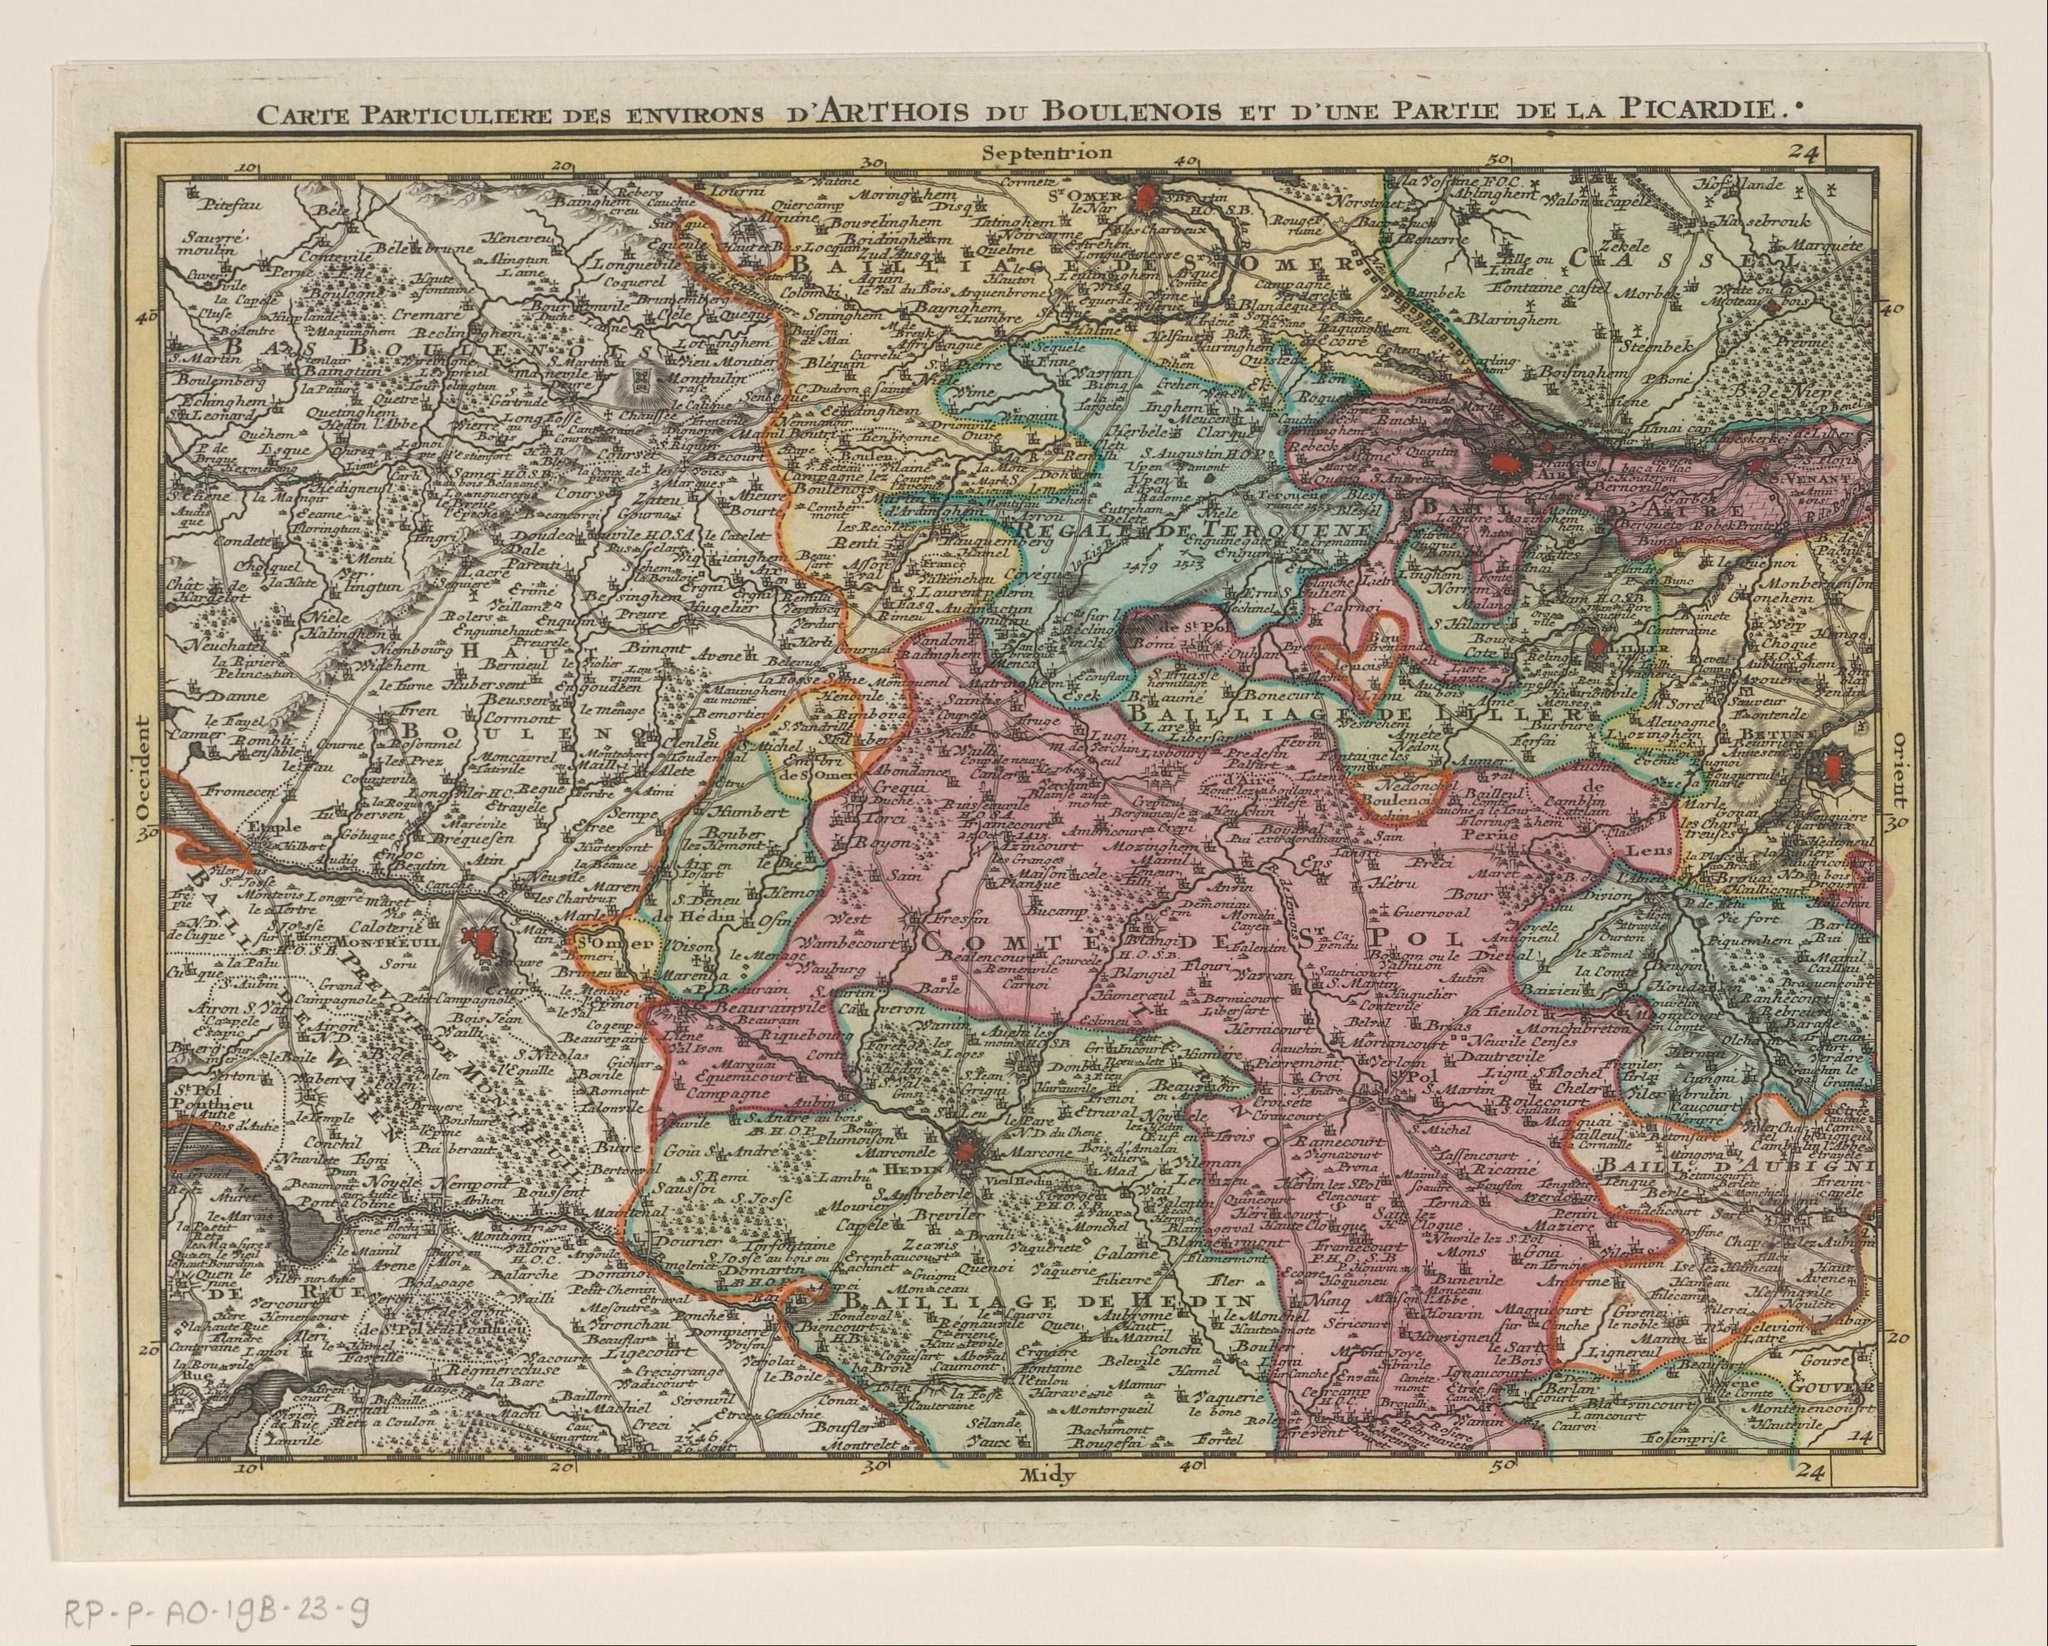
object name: map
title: Carte particuliere des environs d'Artois du Boulenoi et d'une partie de la Picartdie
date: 1737-1757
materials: paper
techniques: engraving, hand coloring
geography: augsburg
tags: maps of separate countries or regions, southern netherlands, belgium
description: Deze kaart is onderdeel van een wandkaart van de Oostenrijkse Nederlanden, bestaande uit vier rijen van zes delen. De delen van de kaart zijn rechtsonder genummerd, beginnend bij het deel linksboven (1) tot het deel rechtsonder (24).